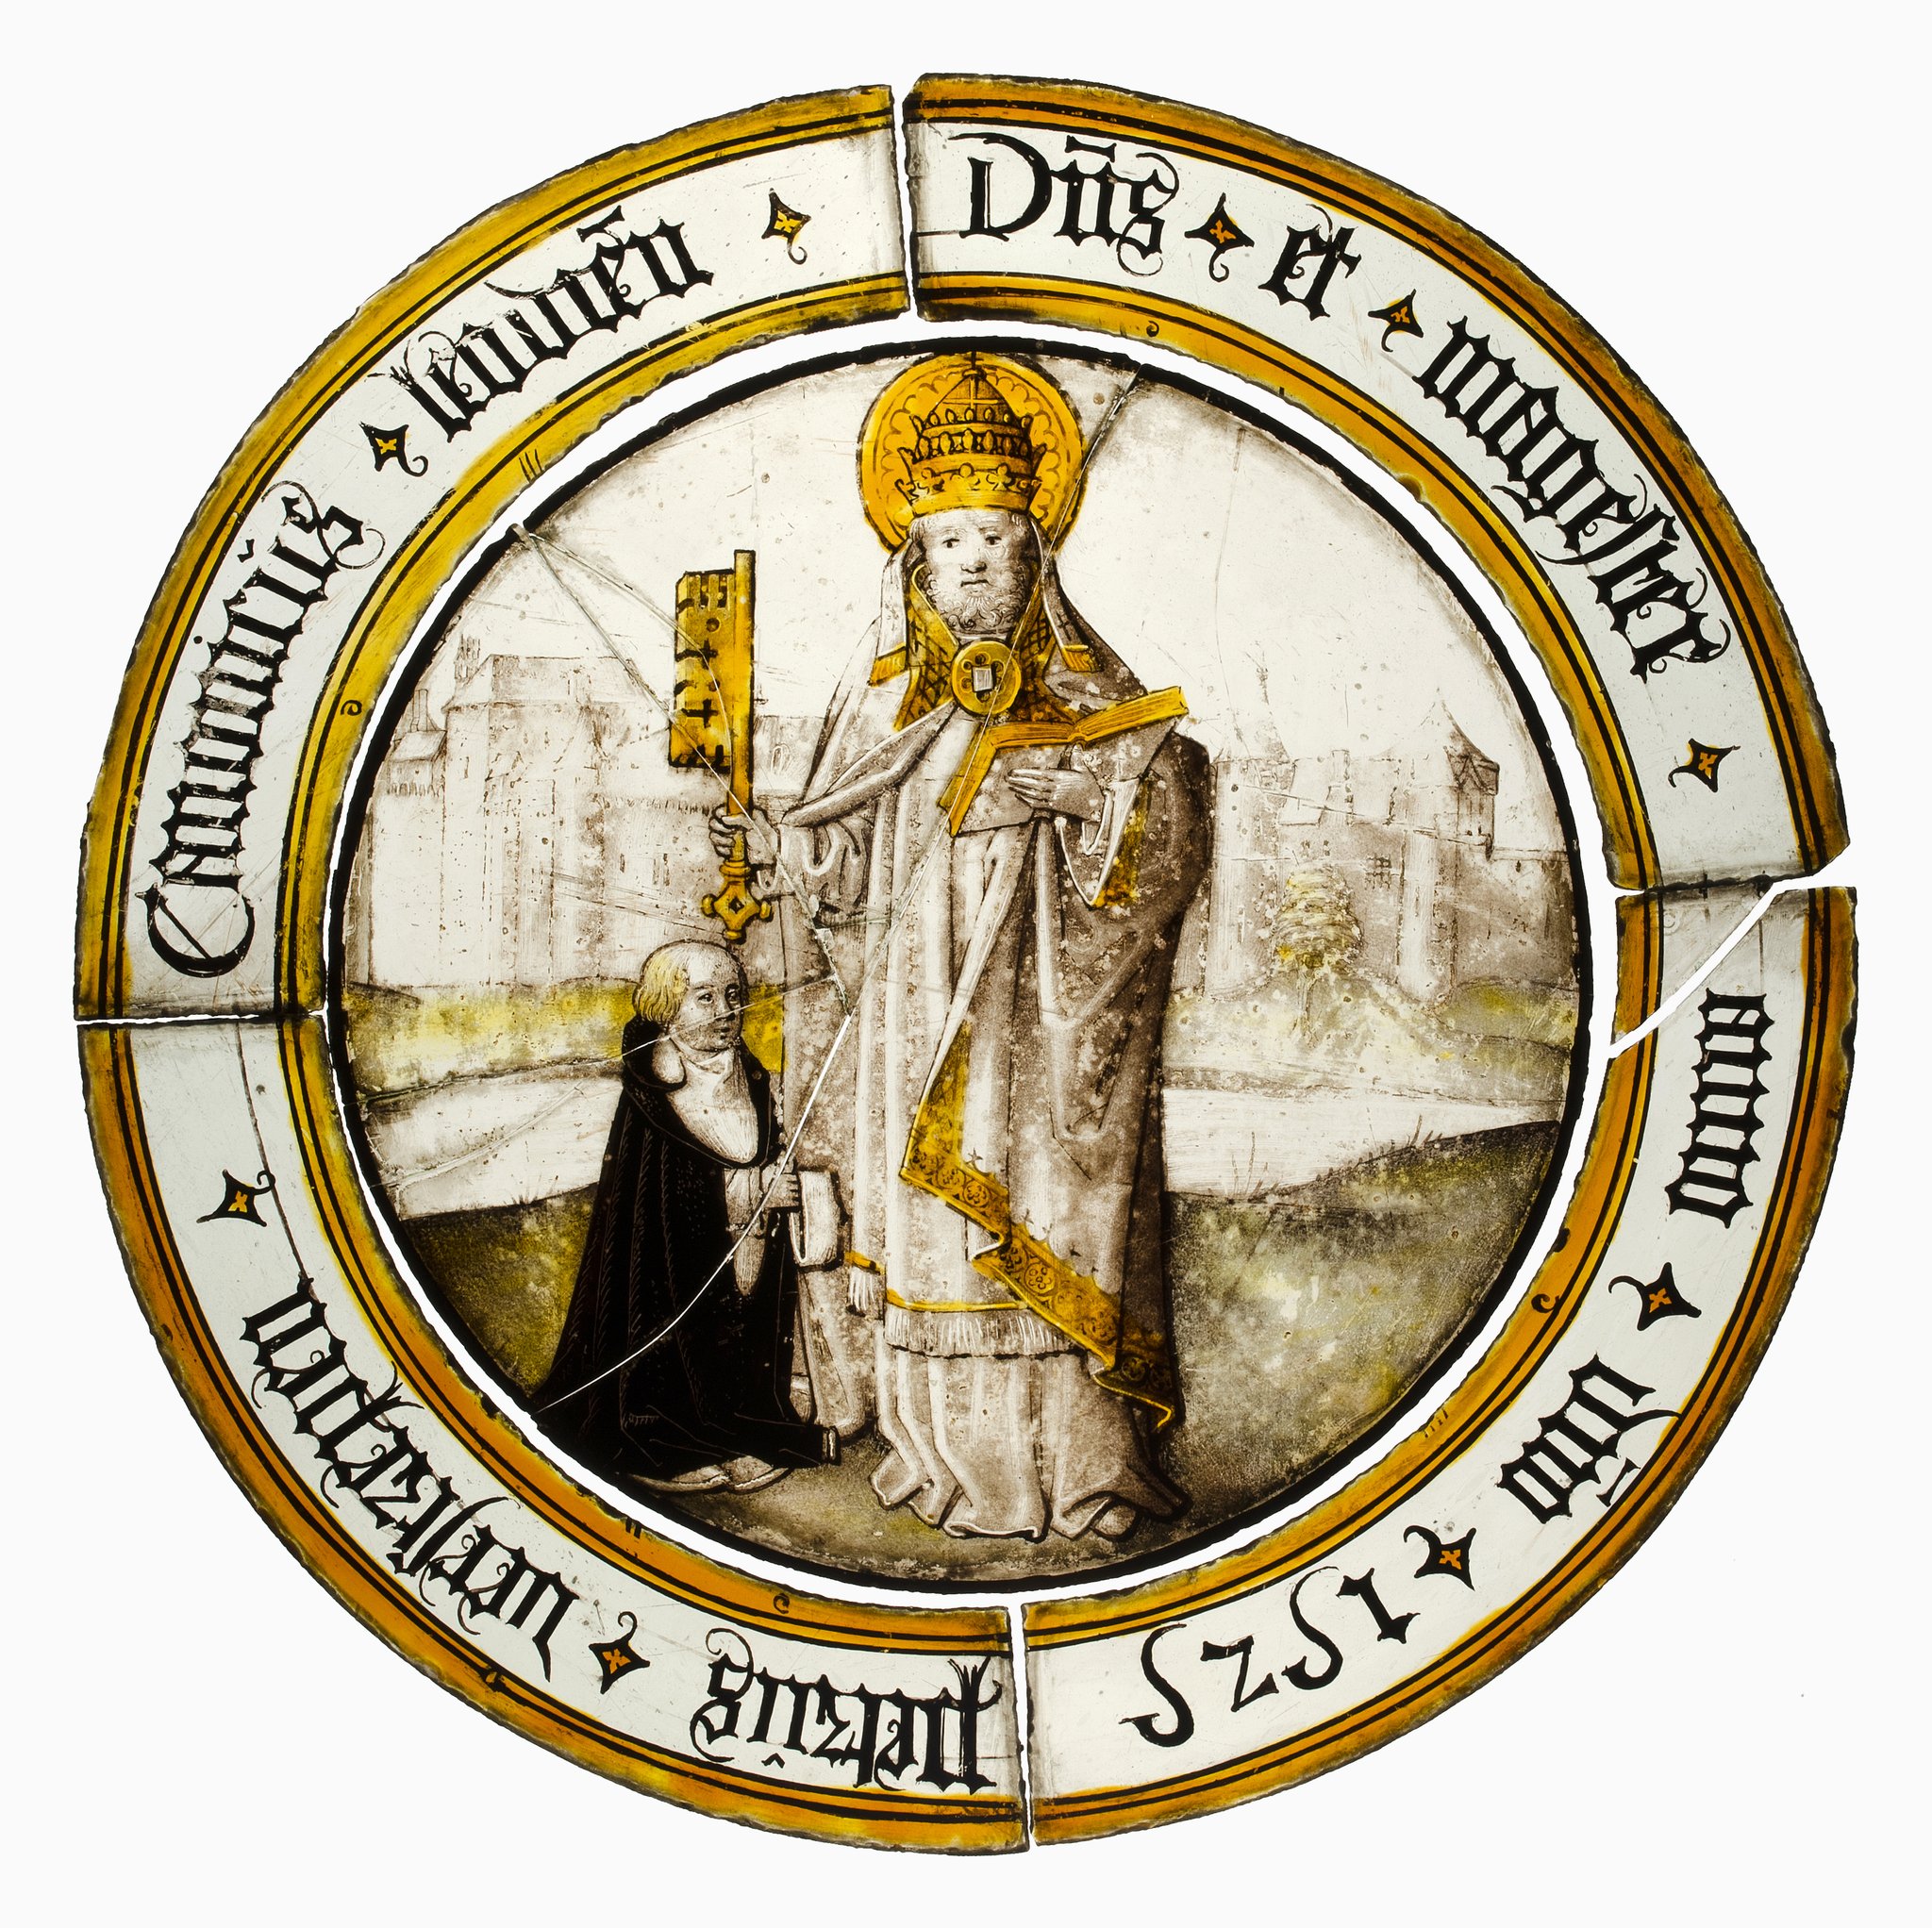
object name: roundel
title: Roundel with Saint Peter as Pope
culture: south netherlandish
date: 1525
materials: glass, paint, pigment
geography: south netherlands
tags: popes,saint peter,keys